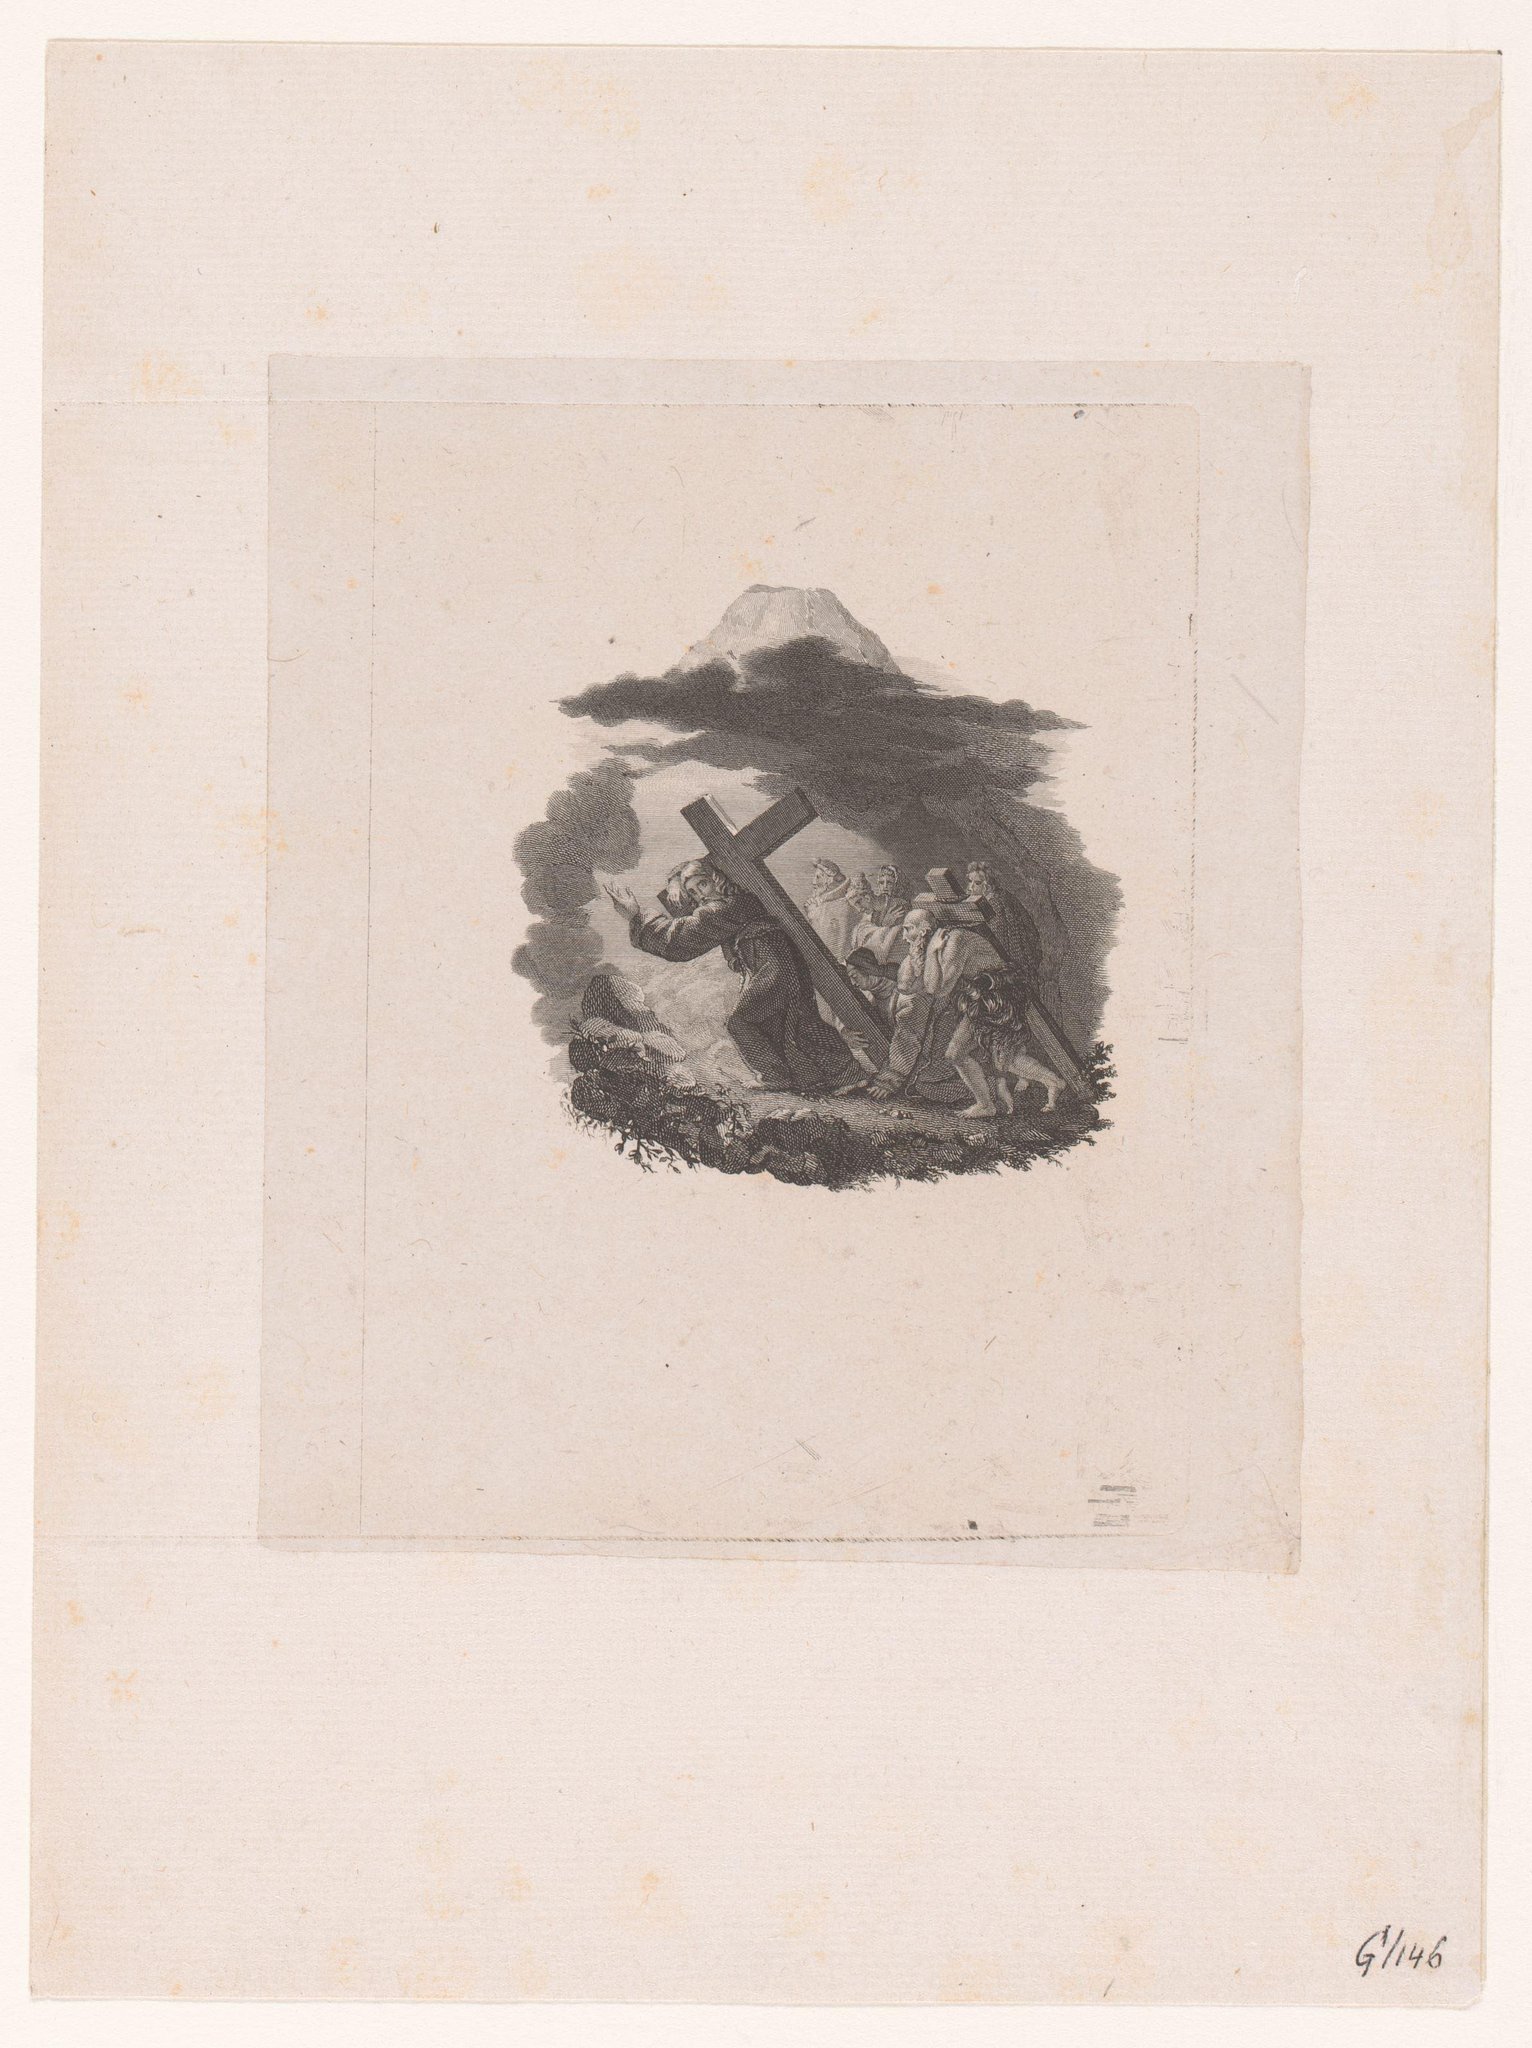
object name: print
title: Kruisdraging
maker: Anonymous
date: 1800-1840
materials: paper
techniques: engraving, etching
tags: carrying of the cross: christ bearing the cross, alone or with the help of others (e.g. simon the cyrenian)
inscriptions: collector's mark: Lugt 2228